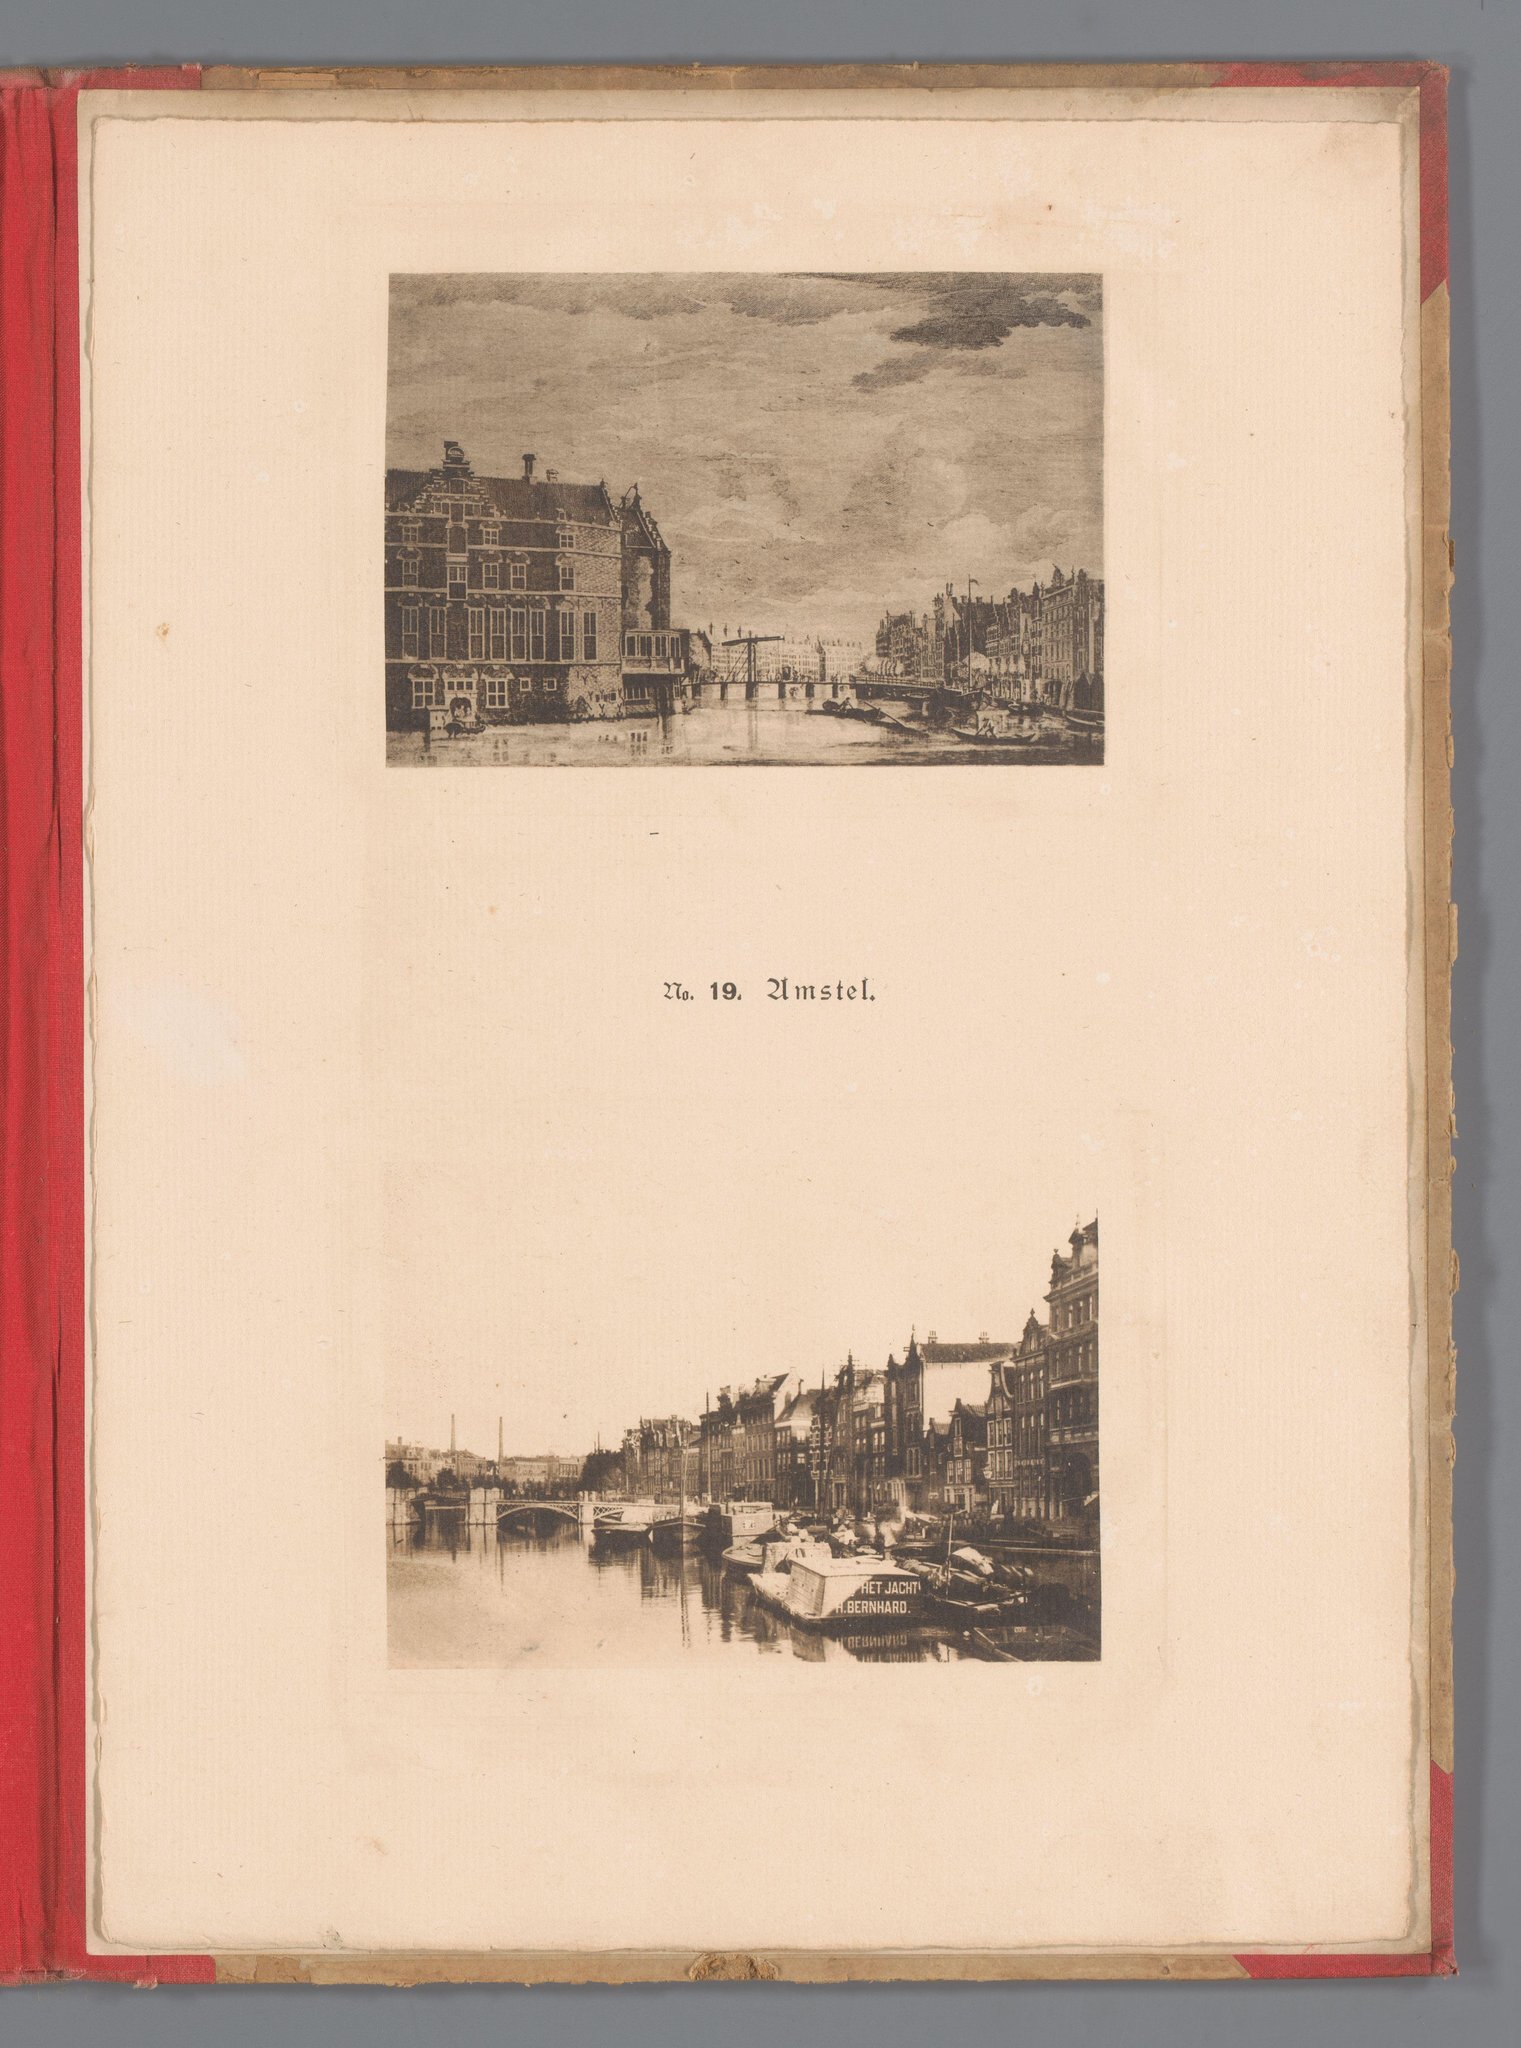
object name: photomechanical print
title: No. 19. Amstel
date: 1890-1900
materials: paper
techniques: photograph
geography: amsterdam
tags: canals, waters (in city) (+ city(-scape) with figures, staffage), old-people's home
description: Deze prenten maken deel uit van een album.